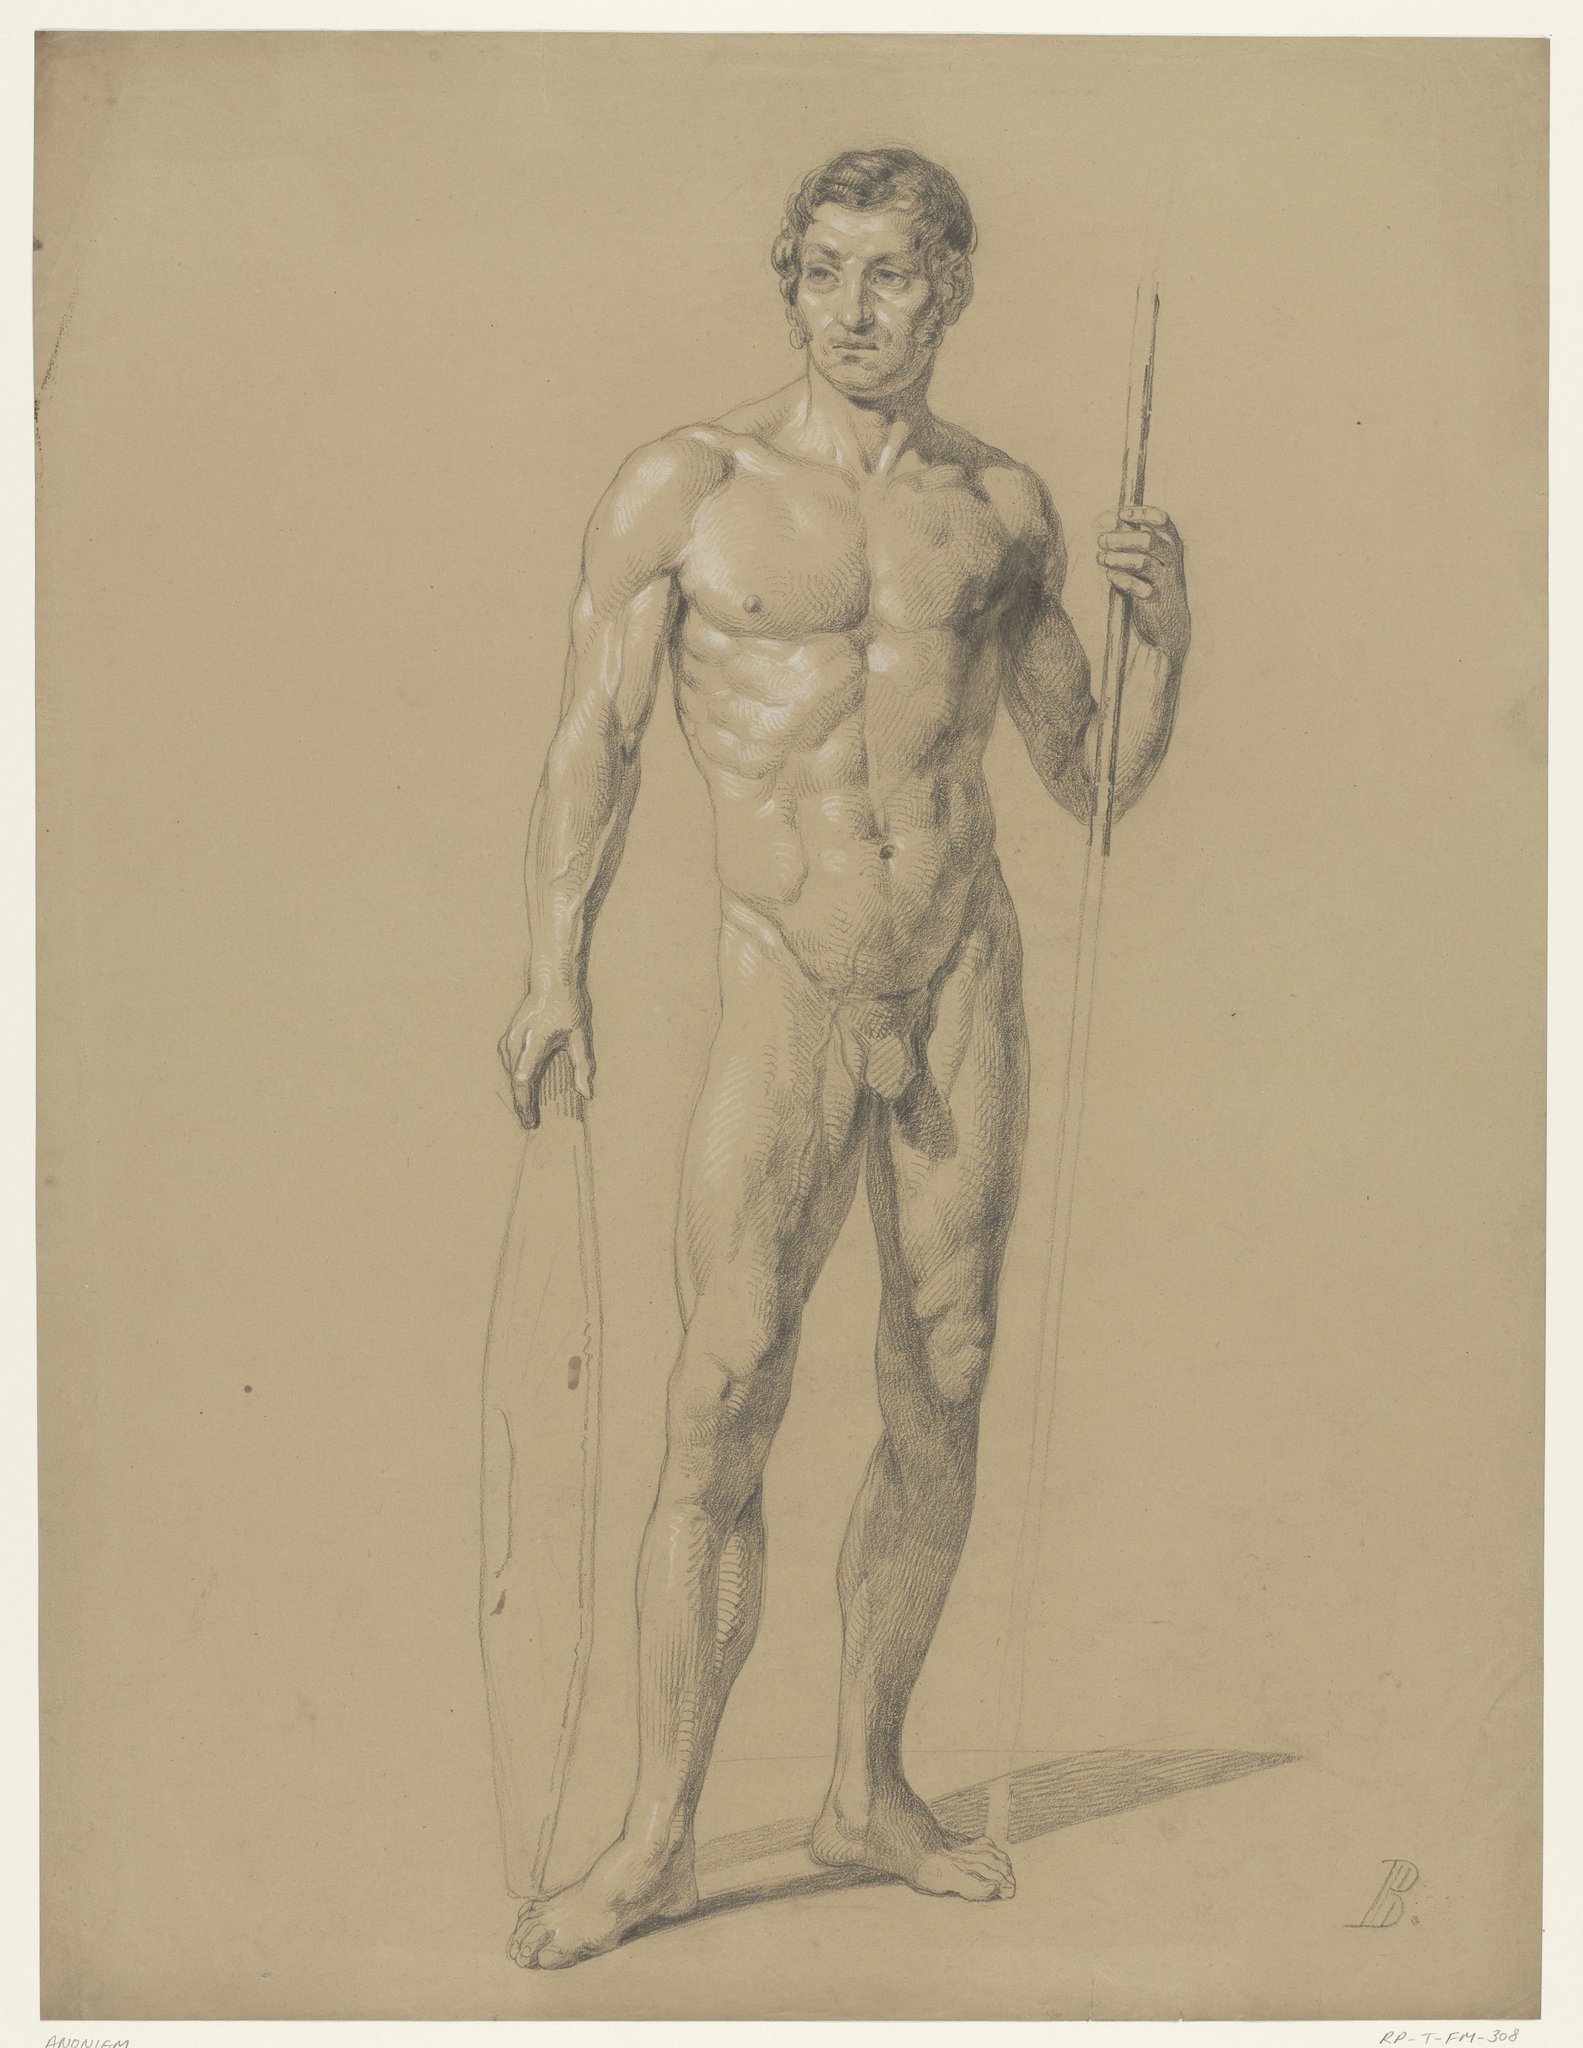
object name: drawing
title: Staand mannelijk naakt met een schild en speer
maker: Anonymous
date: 1842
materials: chalk, paper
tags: standing figure